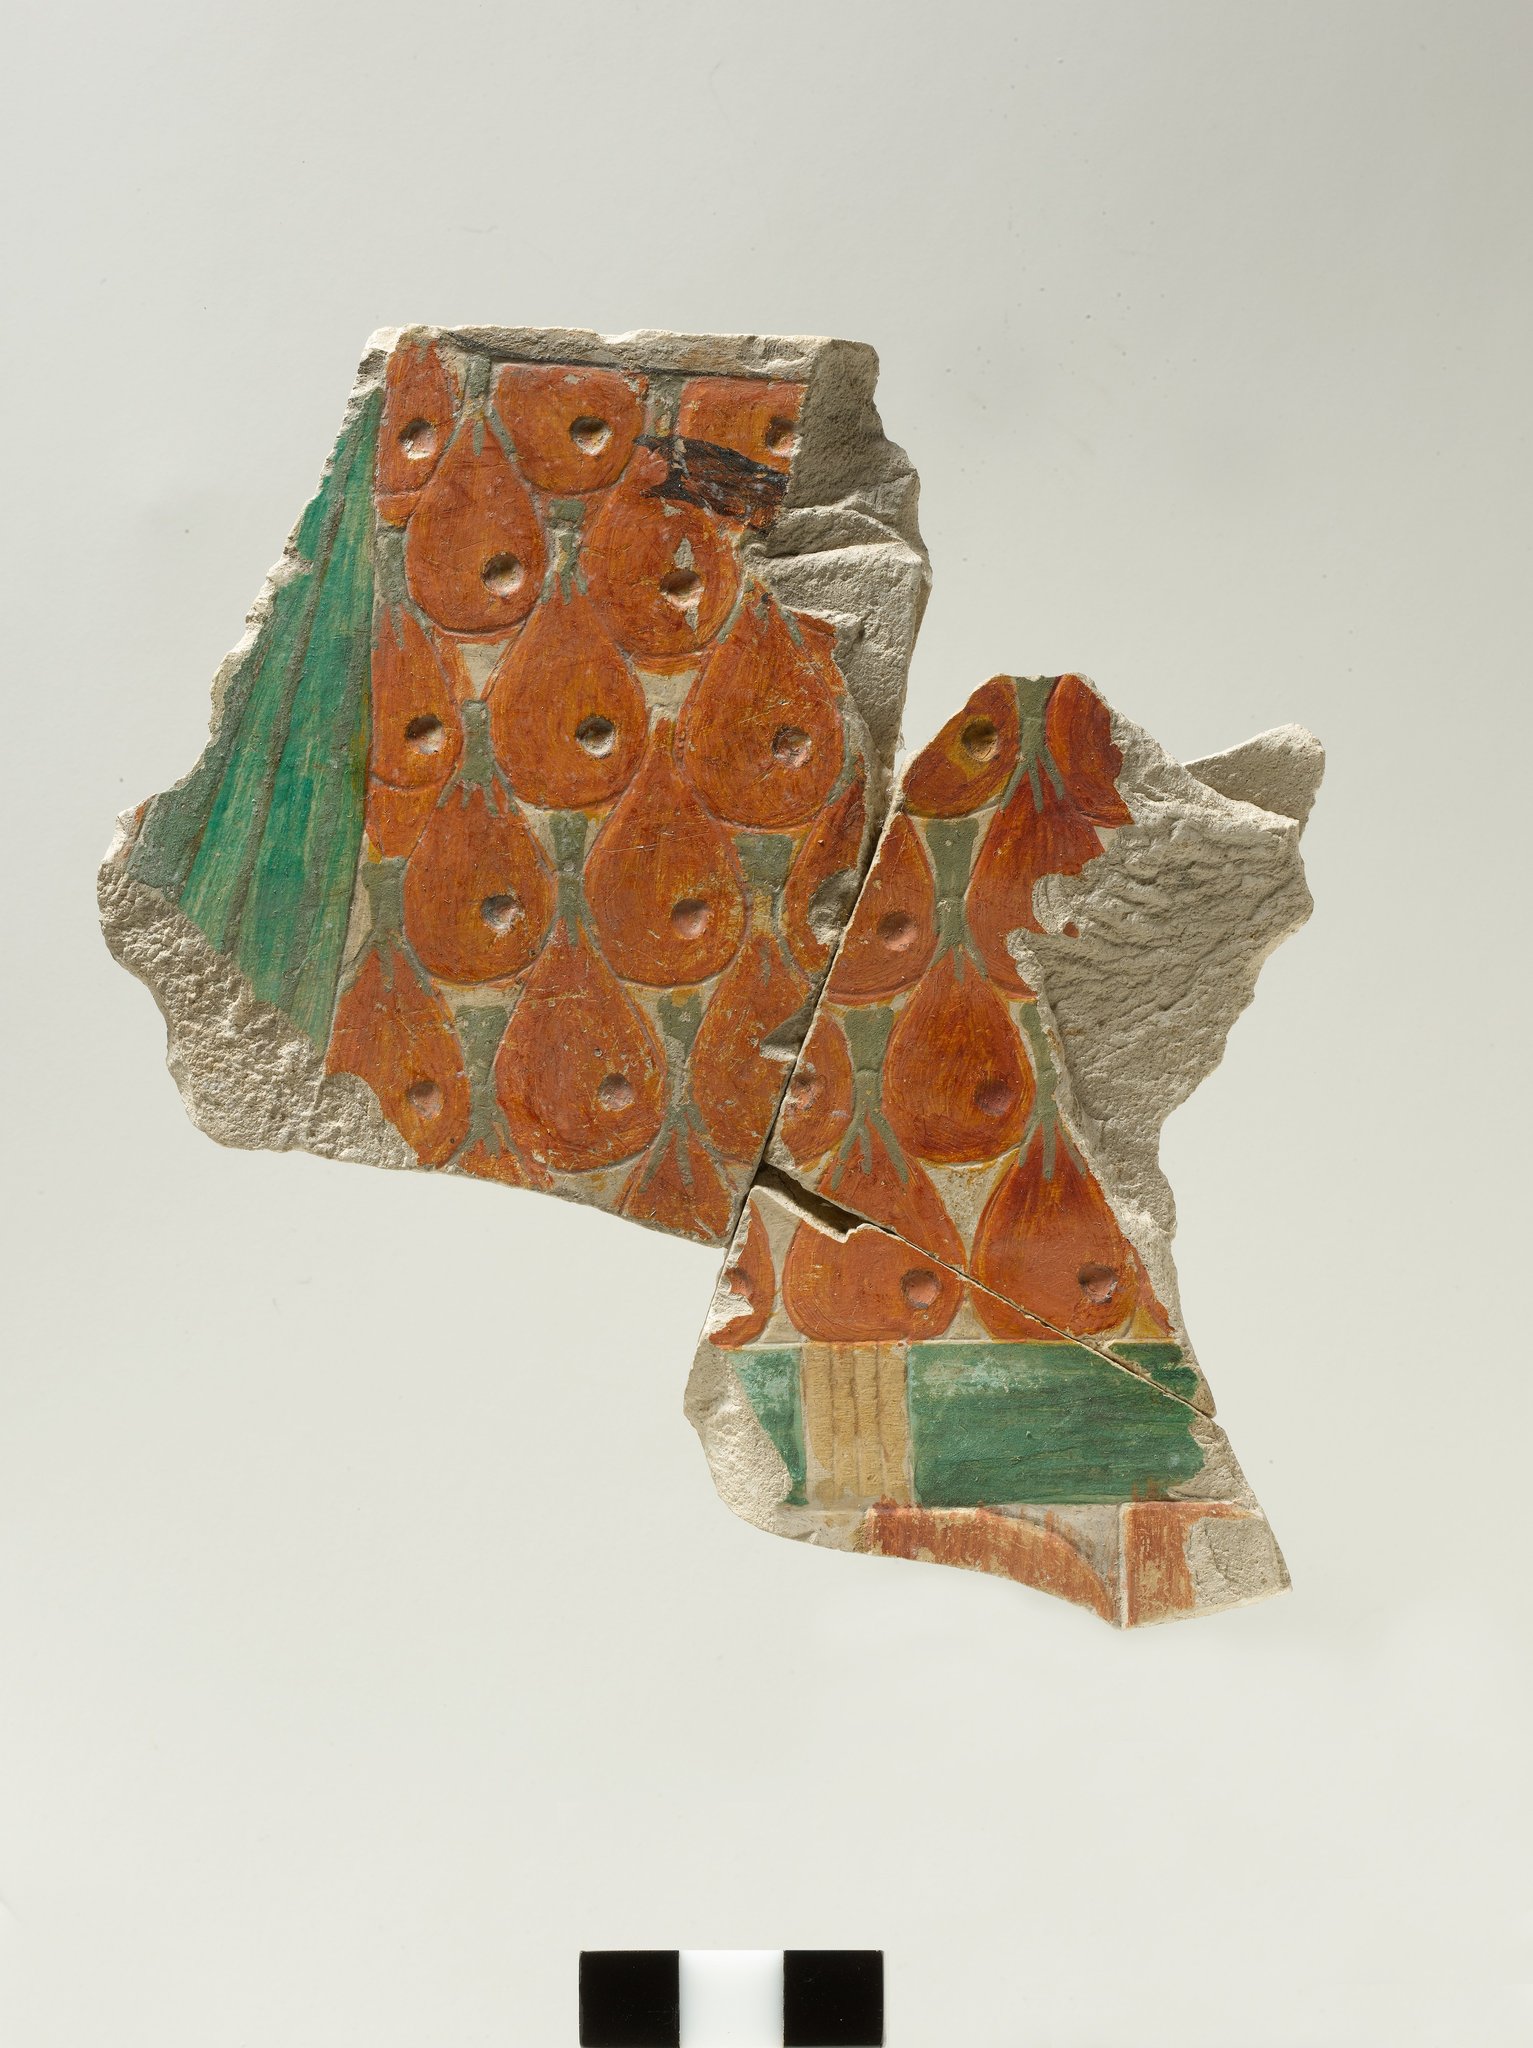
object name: relief fragment, tomb of meketre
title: Relief fragment from the tomb of Meketre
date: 1981-1975 BCE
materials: limestone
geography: egypt